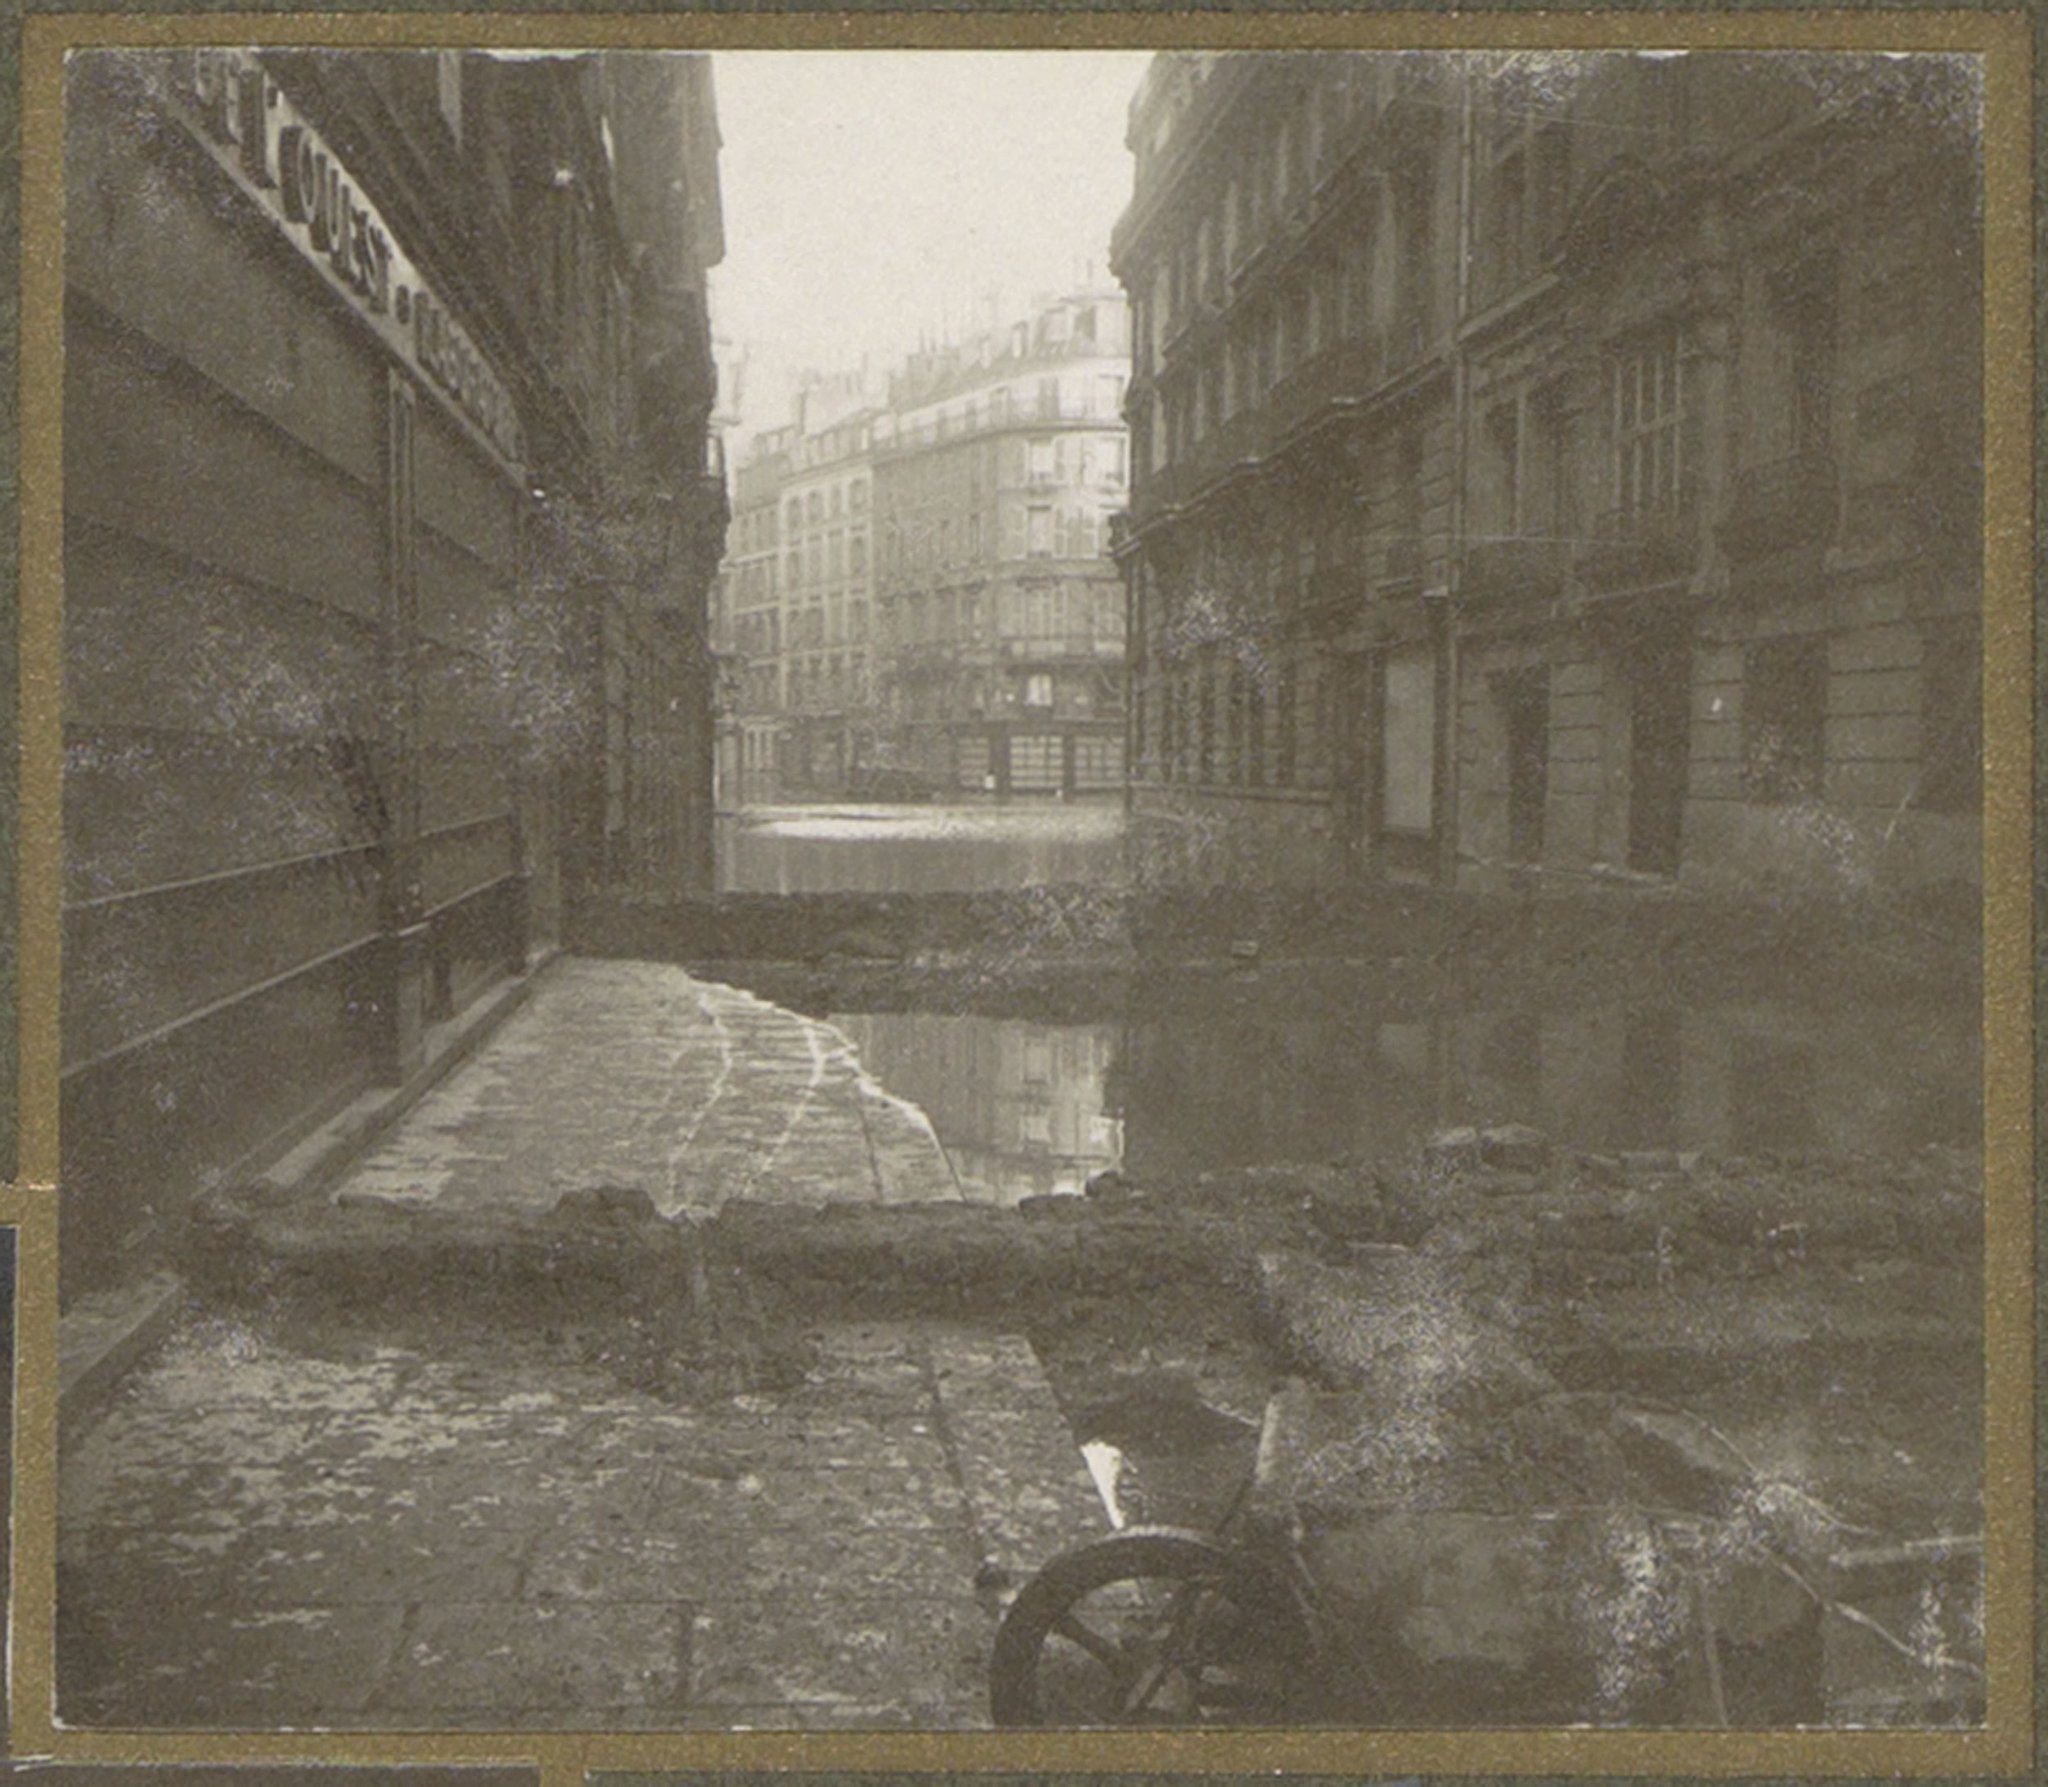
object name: photograph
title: Ondergelopen straat met dammen en een kruiwagen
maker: g. dangereux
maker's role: fotograaf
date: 1901-1910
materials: photographic support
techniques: matte daylight collodion silver print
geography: paris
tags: flood (+ landscape with figures, staffage), wheelbarrow, paris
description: Onderdeel van fotoalbum overstroming Parijs en voorsteden 1910.